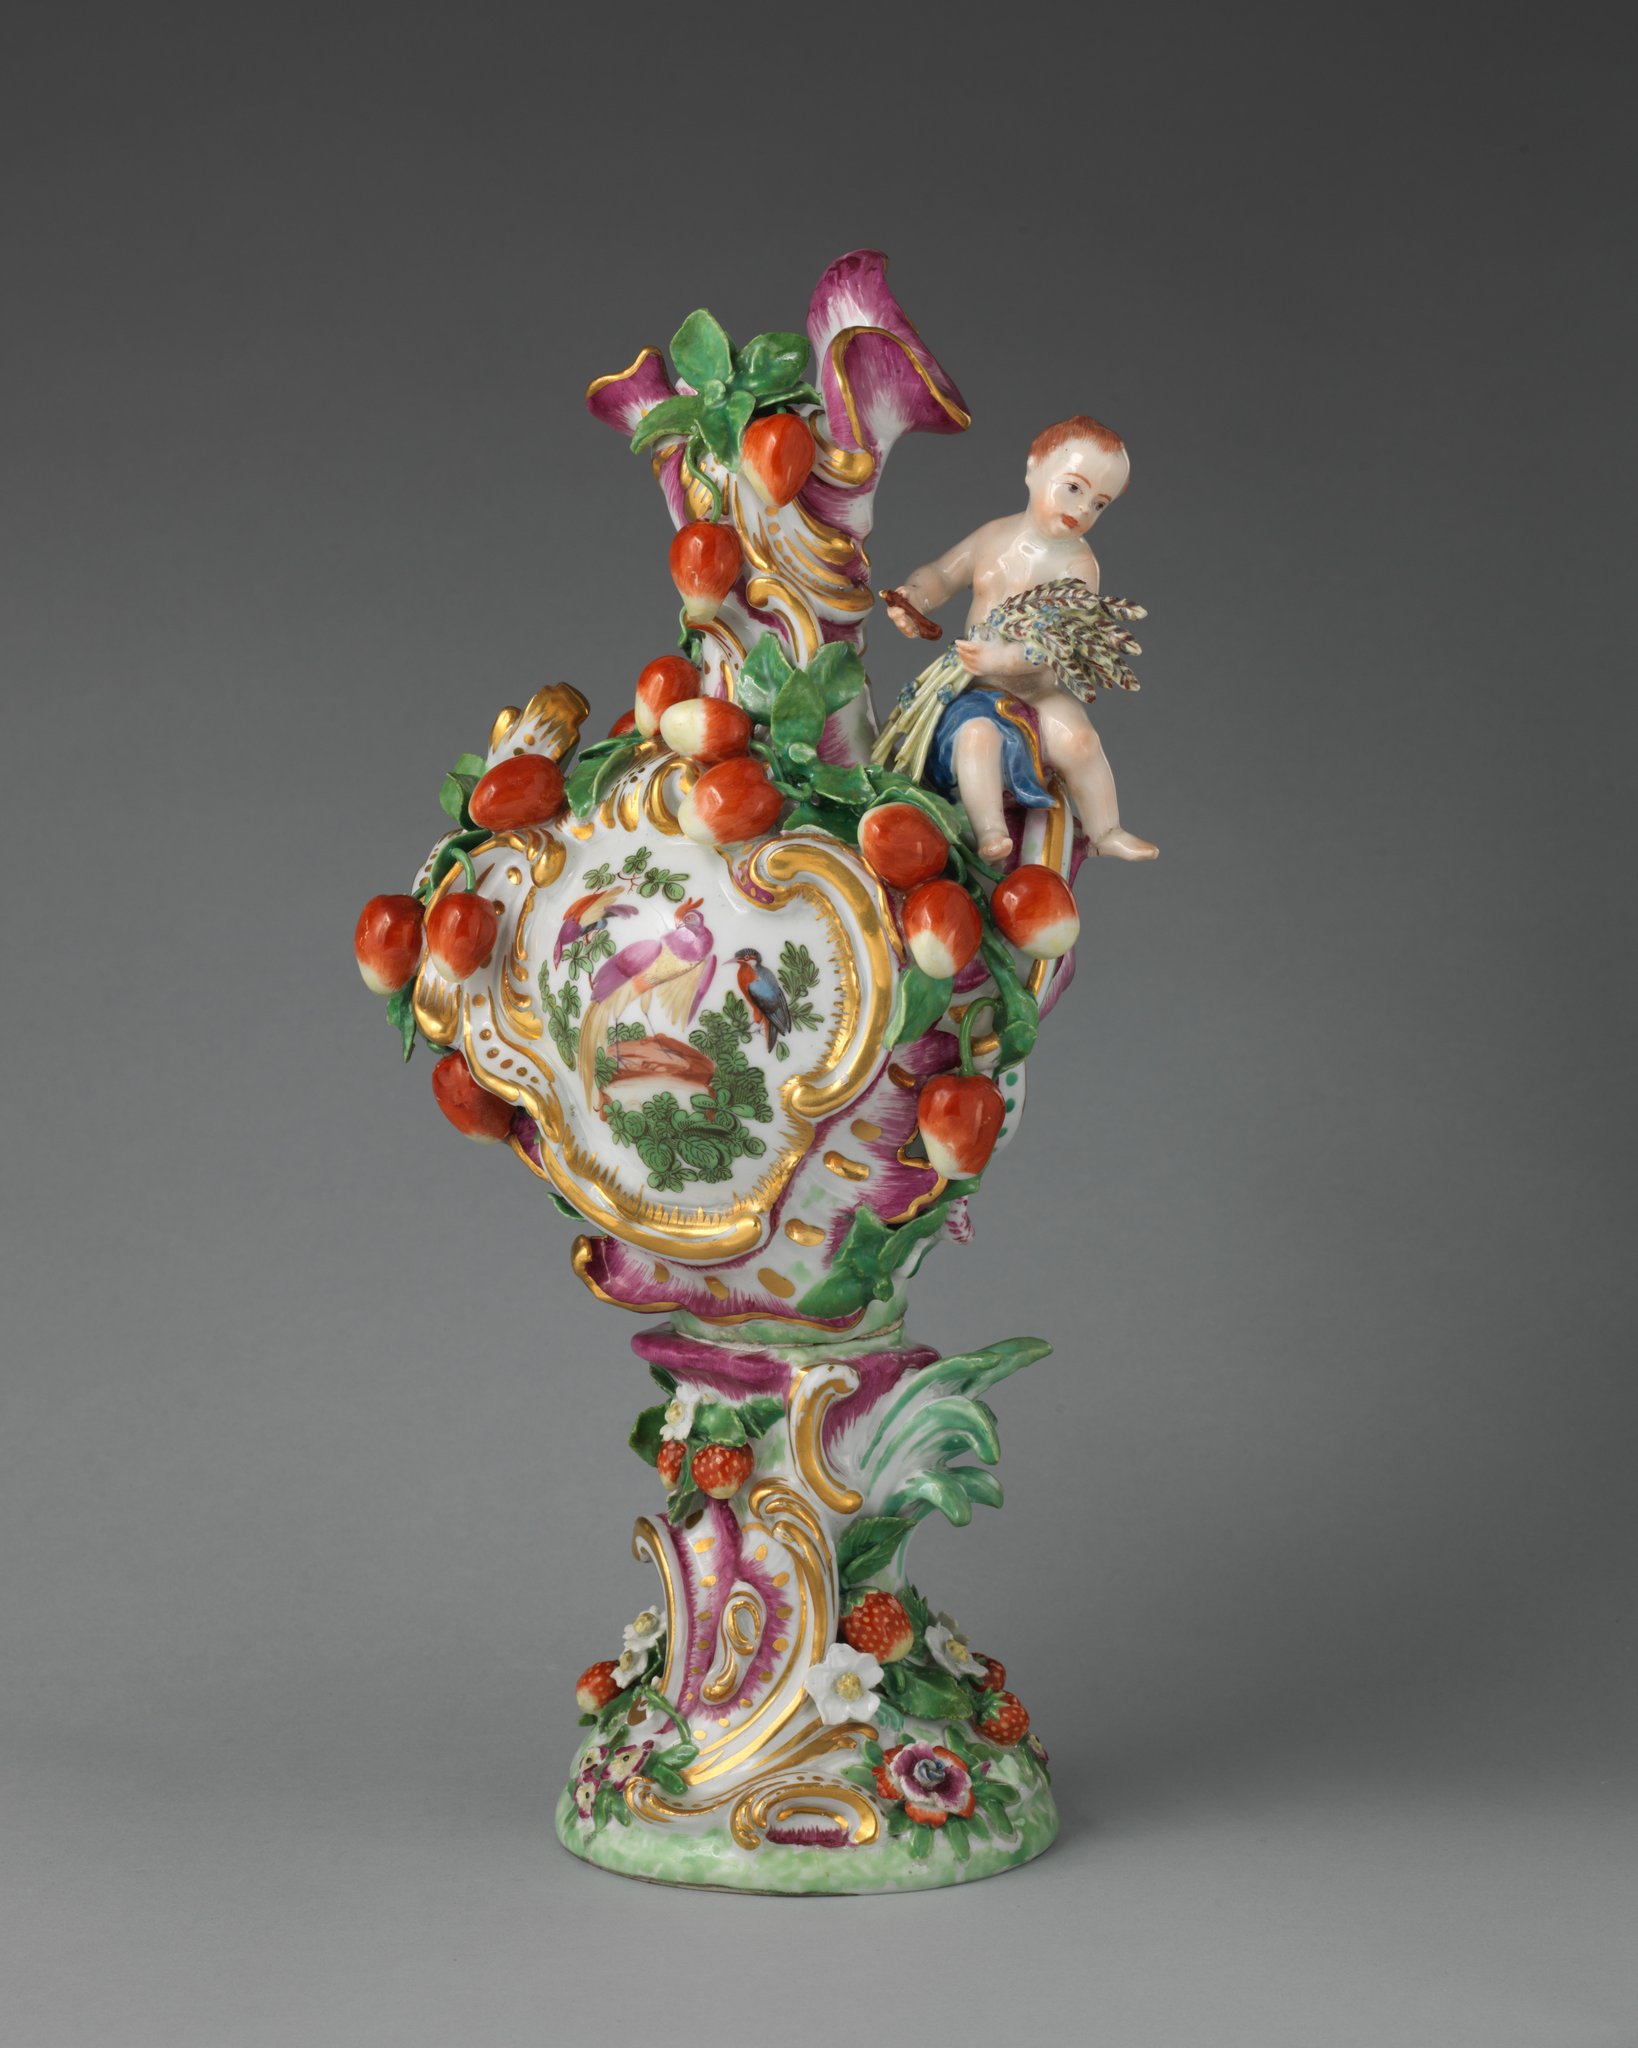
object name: vase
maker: chelsea porcelain manufactory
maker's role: factory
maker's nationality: british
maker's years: 1744-1784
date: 1760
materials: soft paste porcelain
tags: birds,fruit,children,flowers